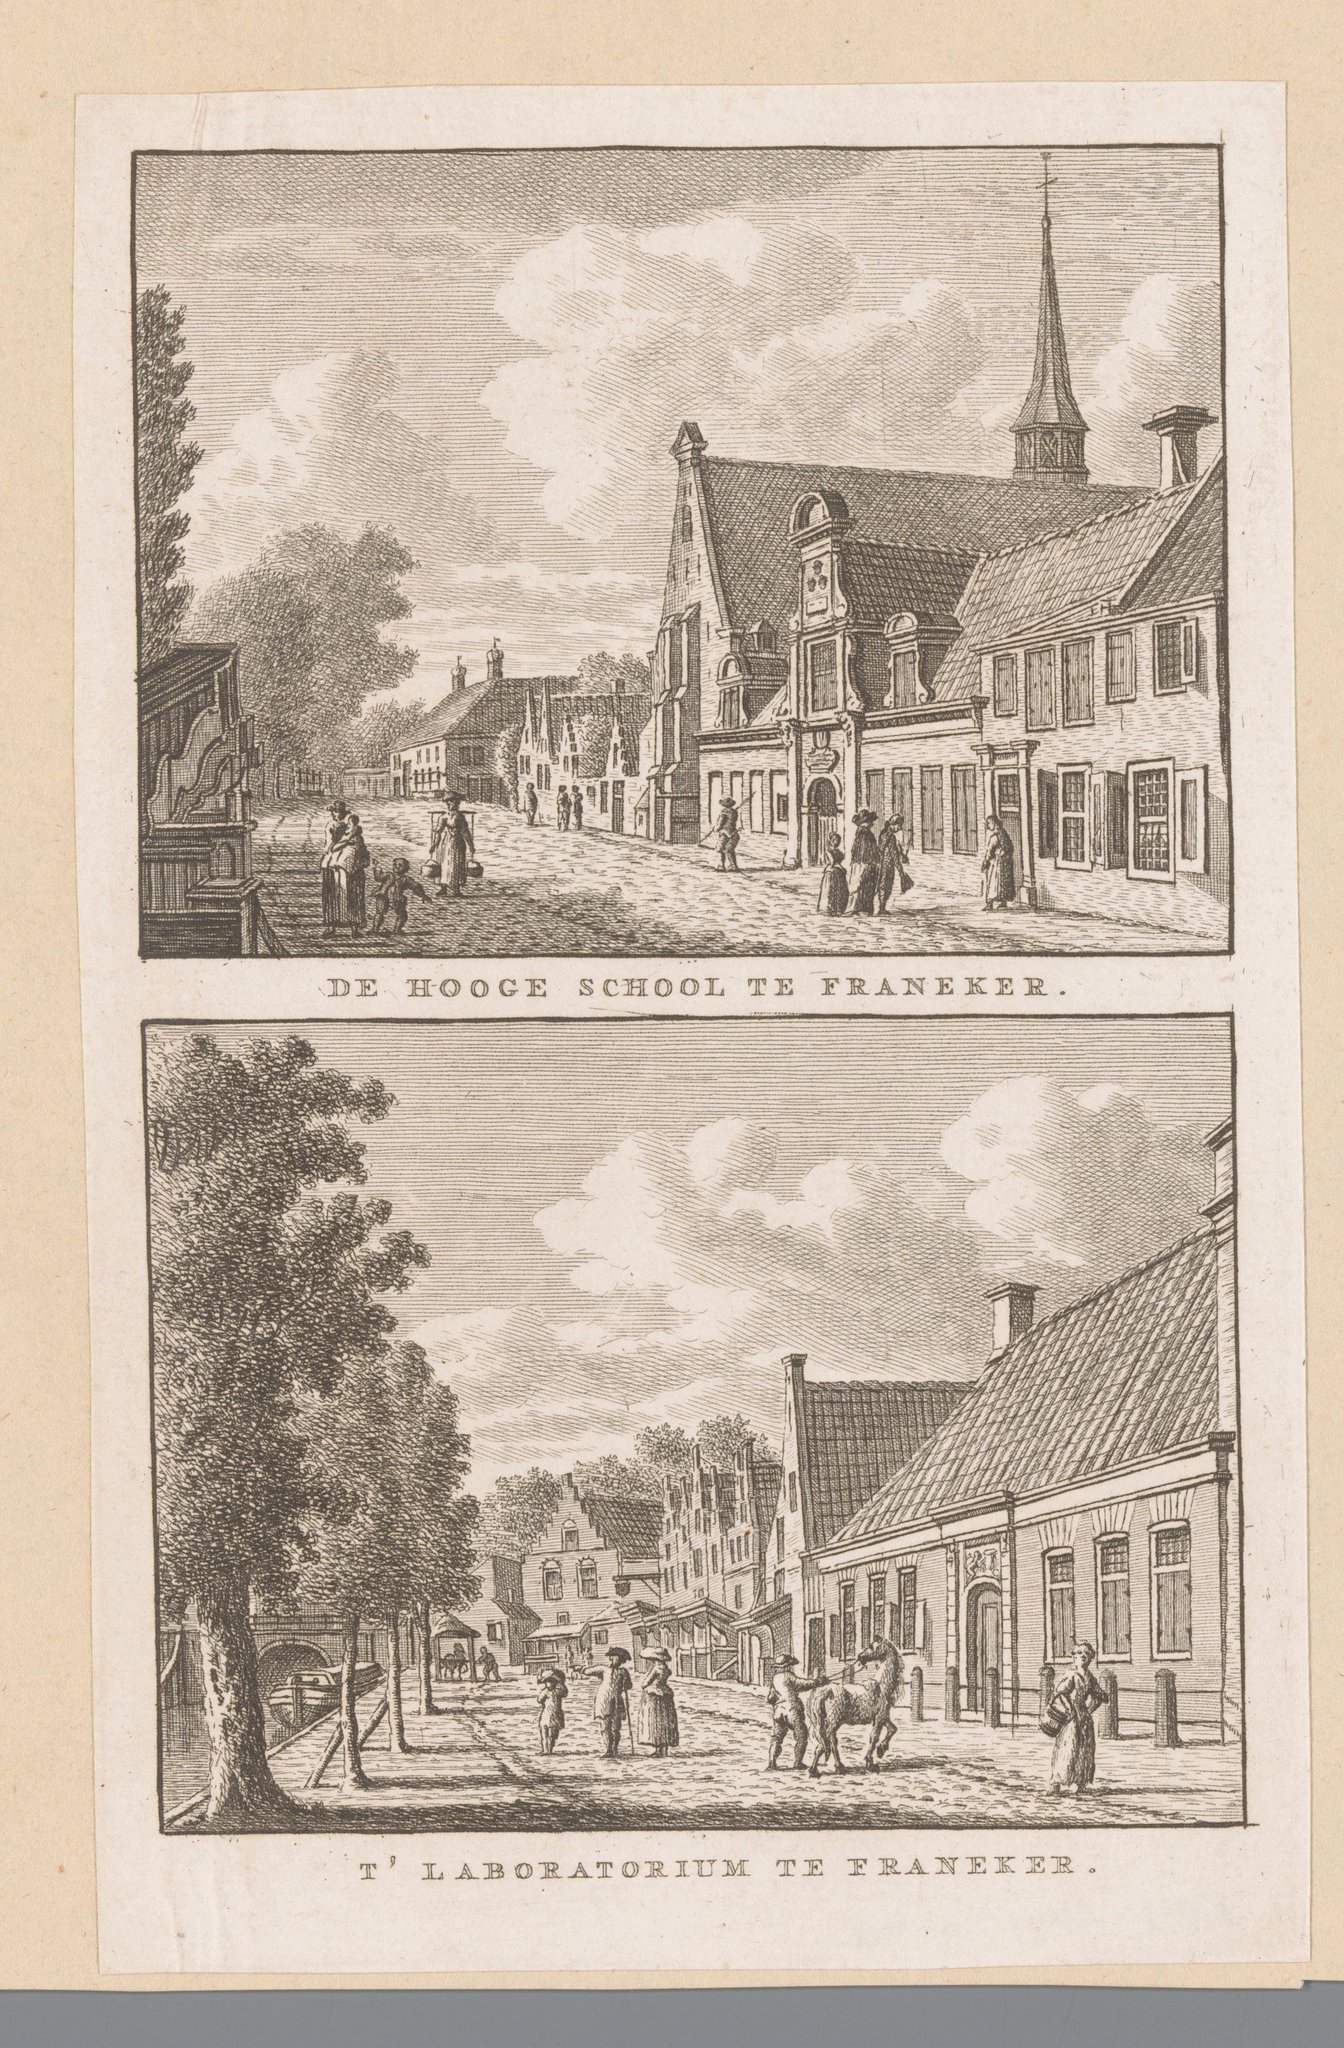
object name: print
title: De Hooge school te Franeker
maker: carel frederik bendorp (i)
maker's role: print maker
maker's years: 1736-1814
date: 1786-1792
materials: paper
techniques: etching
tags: village, scholastic education, tuition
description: Prent uit: Vaderlandsche gezichten, of afbeeldingen van den tegenwoordigen staat der Vereenigde Nederlanden (…). Amsterdam: Hendrik Gartman, Willem Vermandel en Jan Willem Smit, 1786-1792. Uitgegeven in afleveringen met ieder een eigen bifolium en inhoudsopgave. Alle prenten in deze publicatie zijn gegraveerd door Carel Frederik Bendorp (I) en, in de meeste gevallen, gebaseerd op tekeningen van Jan Bulthuis.